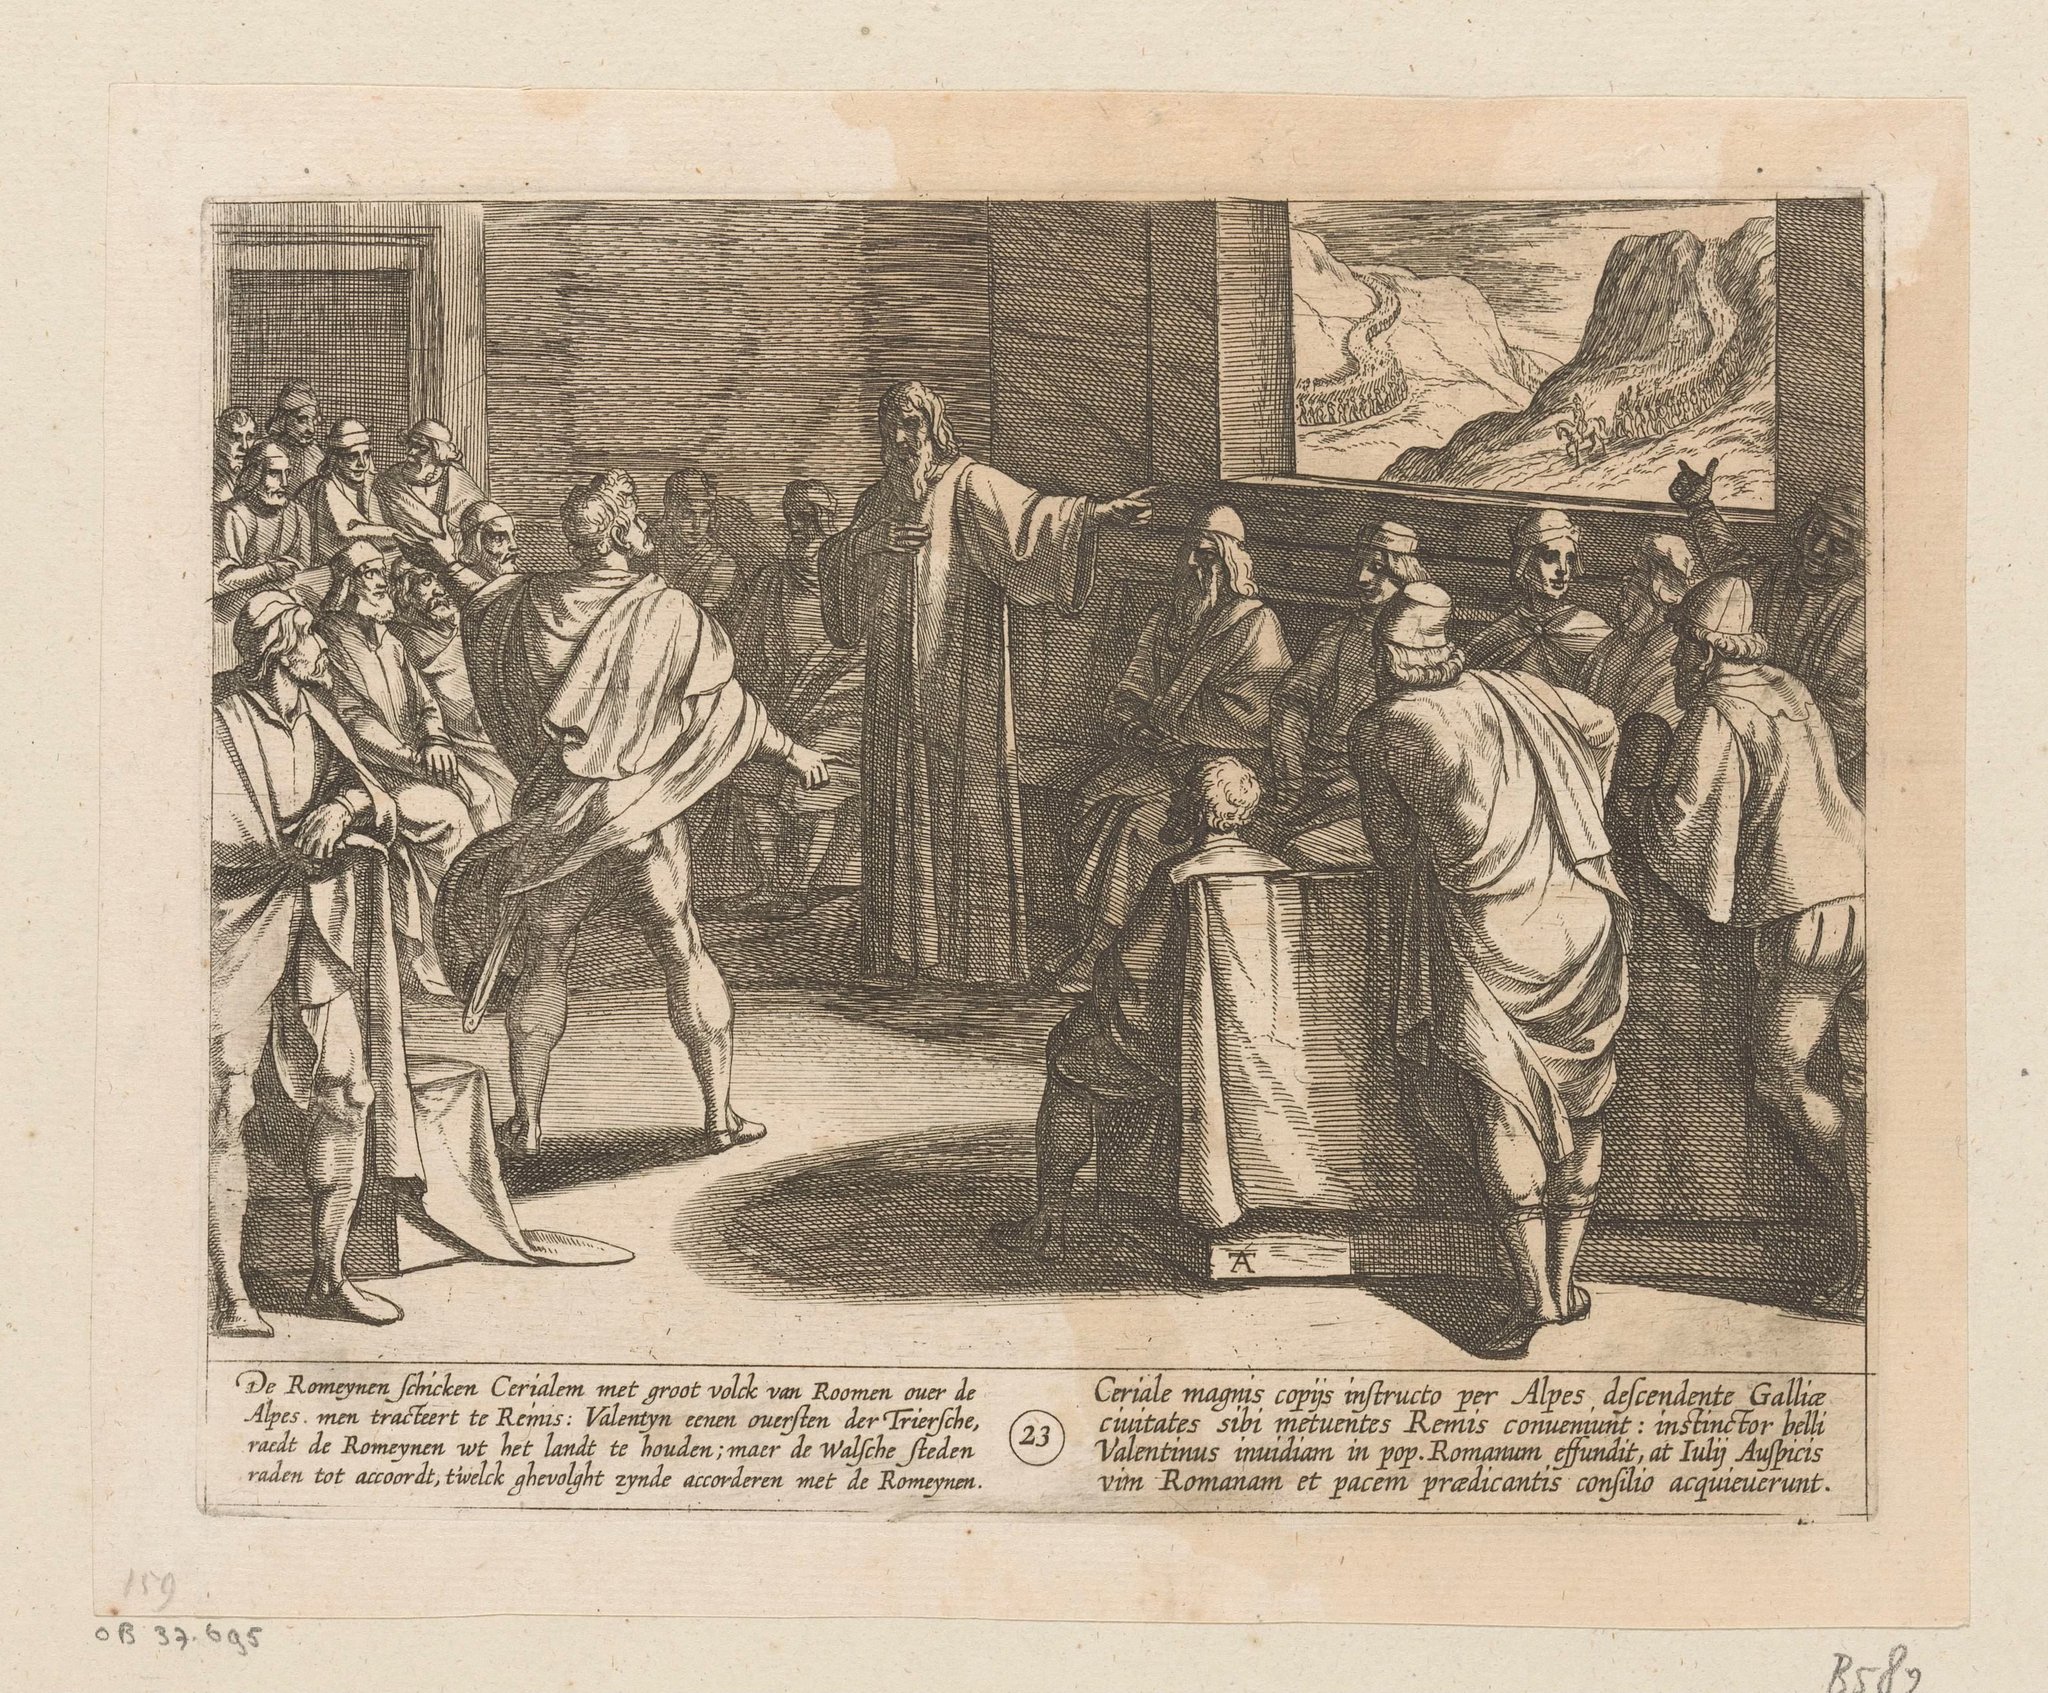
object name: print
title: De Bataafse Opstand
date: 1612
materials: paper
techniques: etching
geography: italy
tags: extinct, 'historical' peoples (with name)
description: Overleg naar aanleiding van de komst van nieuwe Romeinse troepen. Prent nummer 23 in de serie prenten over de Bataafse Opstand: Batavorum cum Romanis bellum / à Corn. Tacito lib. IV & V. : Hist. olim descriptum, figuris nunc aeneis expressum, auctore Othone Vaenio Lugdunobatava = De Batavische oft oude Hollandtsche oorloghe teghen de Romeynen. Otto Vaenius, Antwerpen 1612. Onderaan twee verzen van vier regels in het Nederlands en in het Latijn. Zonder tekst op achterzijde.